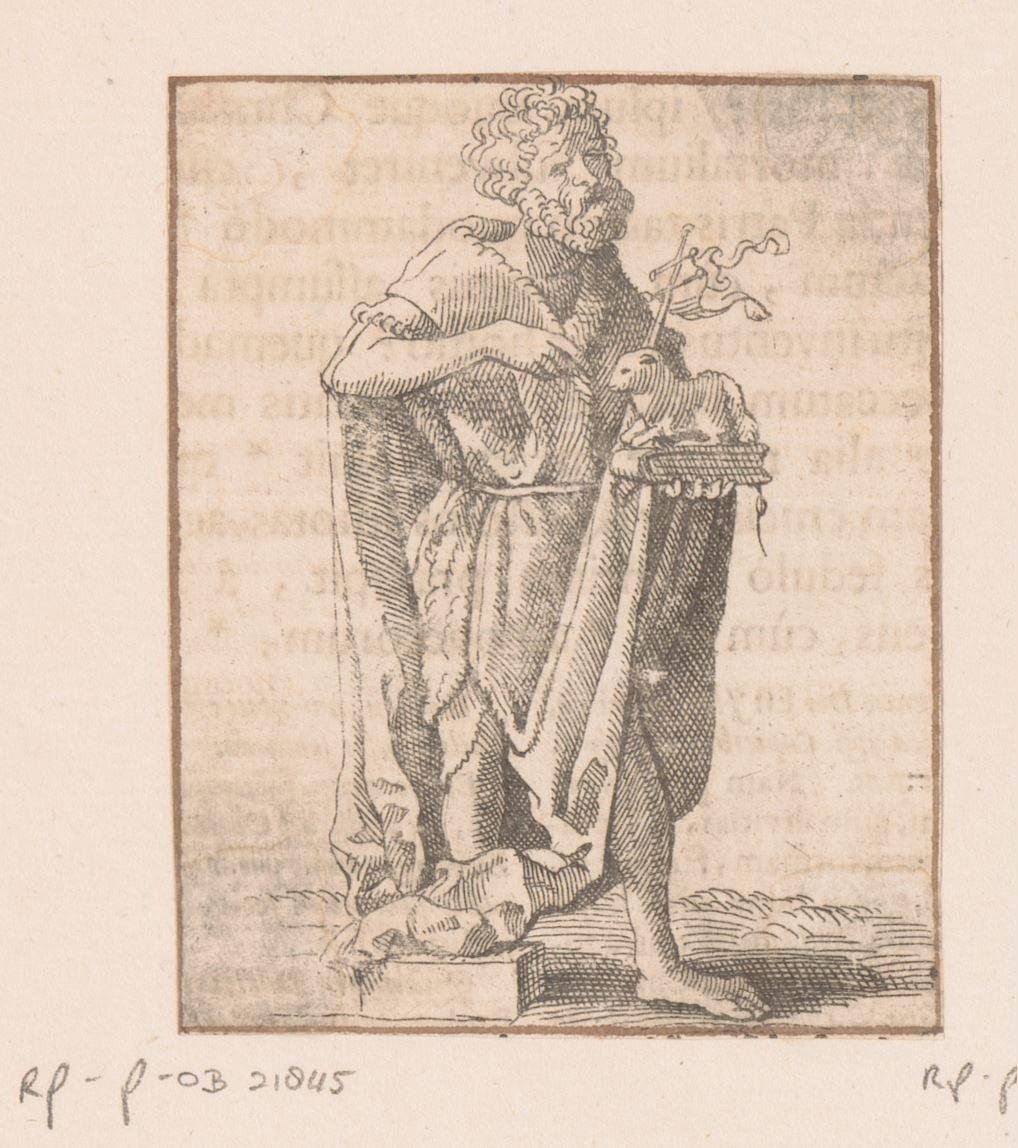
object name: print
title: Johannes de Doper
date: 1516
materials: paper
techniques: etching, letterpress printing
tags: desiderius erasmus, john the baptist; possible attributes: book, reed cross, baptismal cup, honeycomb, lamb, staff, folly, foolishness; 'pazzia', 'sciocchezza', 'stoltitia' (ripa)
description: Prent afkomstig uit: Erasmus, Desiderius. Morias enkomion (...). Bazel: Johann Rudolf Genath, 1676. De prenten hierin zijn naar tekeningen die Hans en Ambrosius Holbein maakten voor de theoloog Oswald Myconius in diens uitgave van de Moriae encomium (Lof der Zotheid) van 1516.